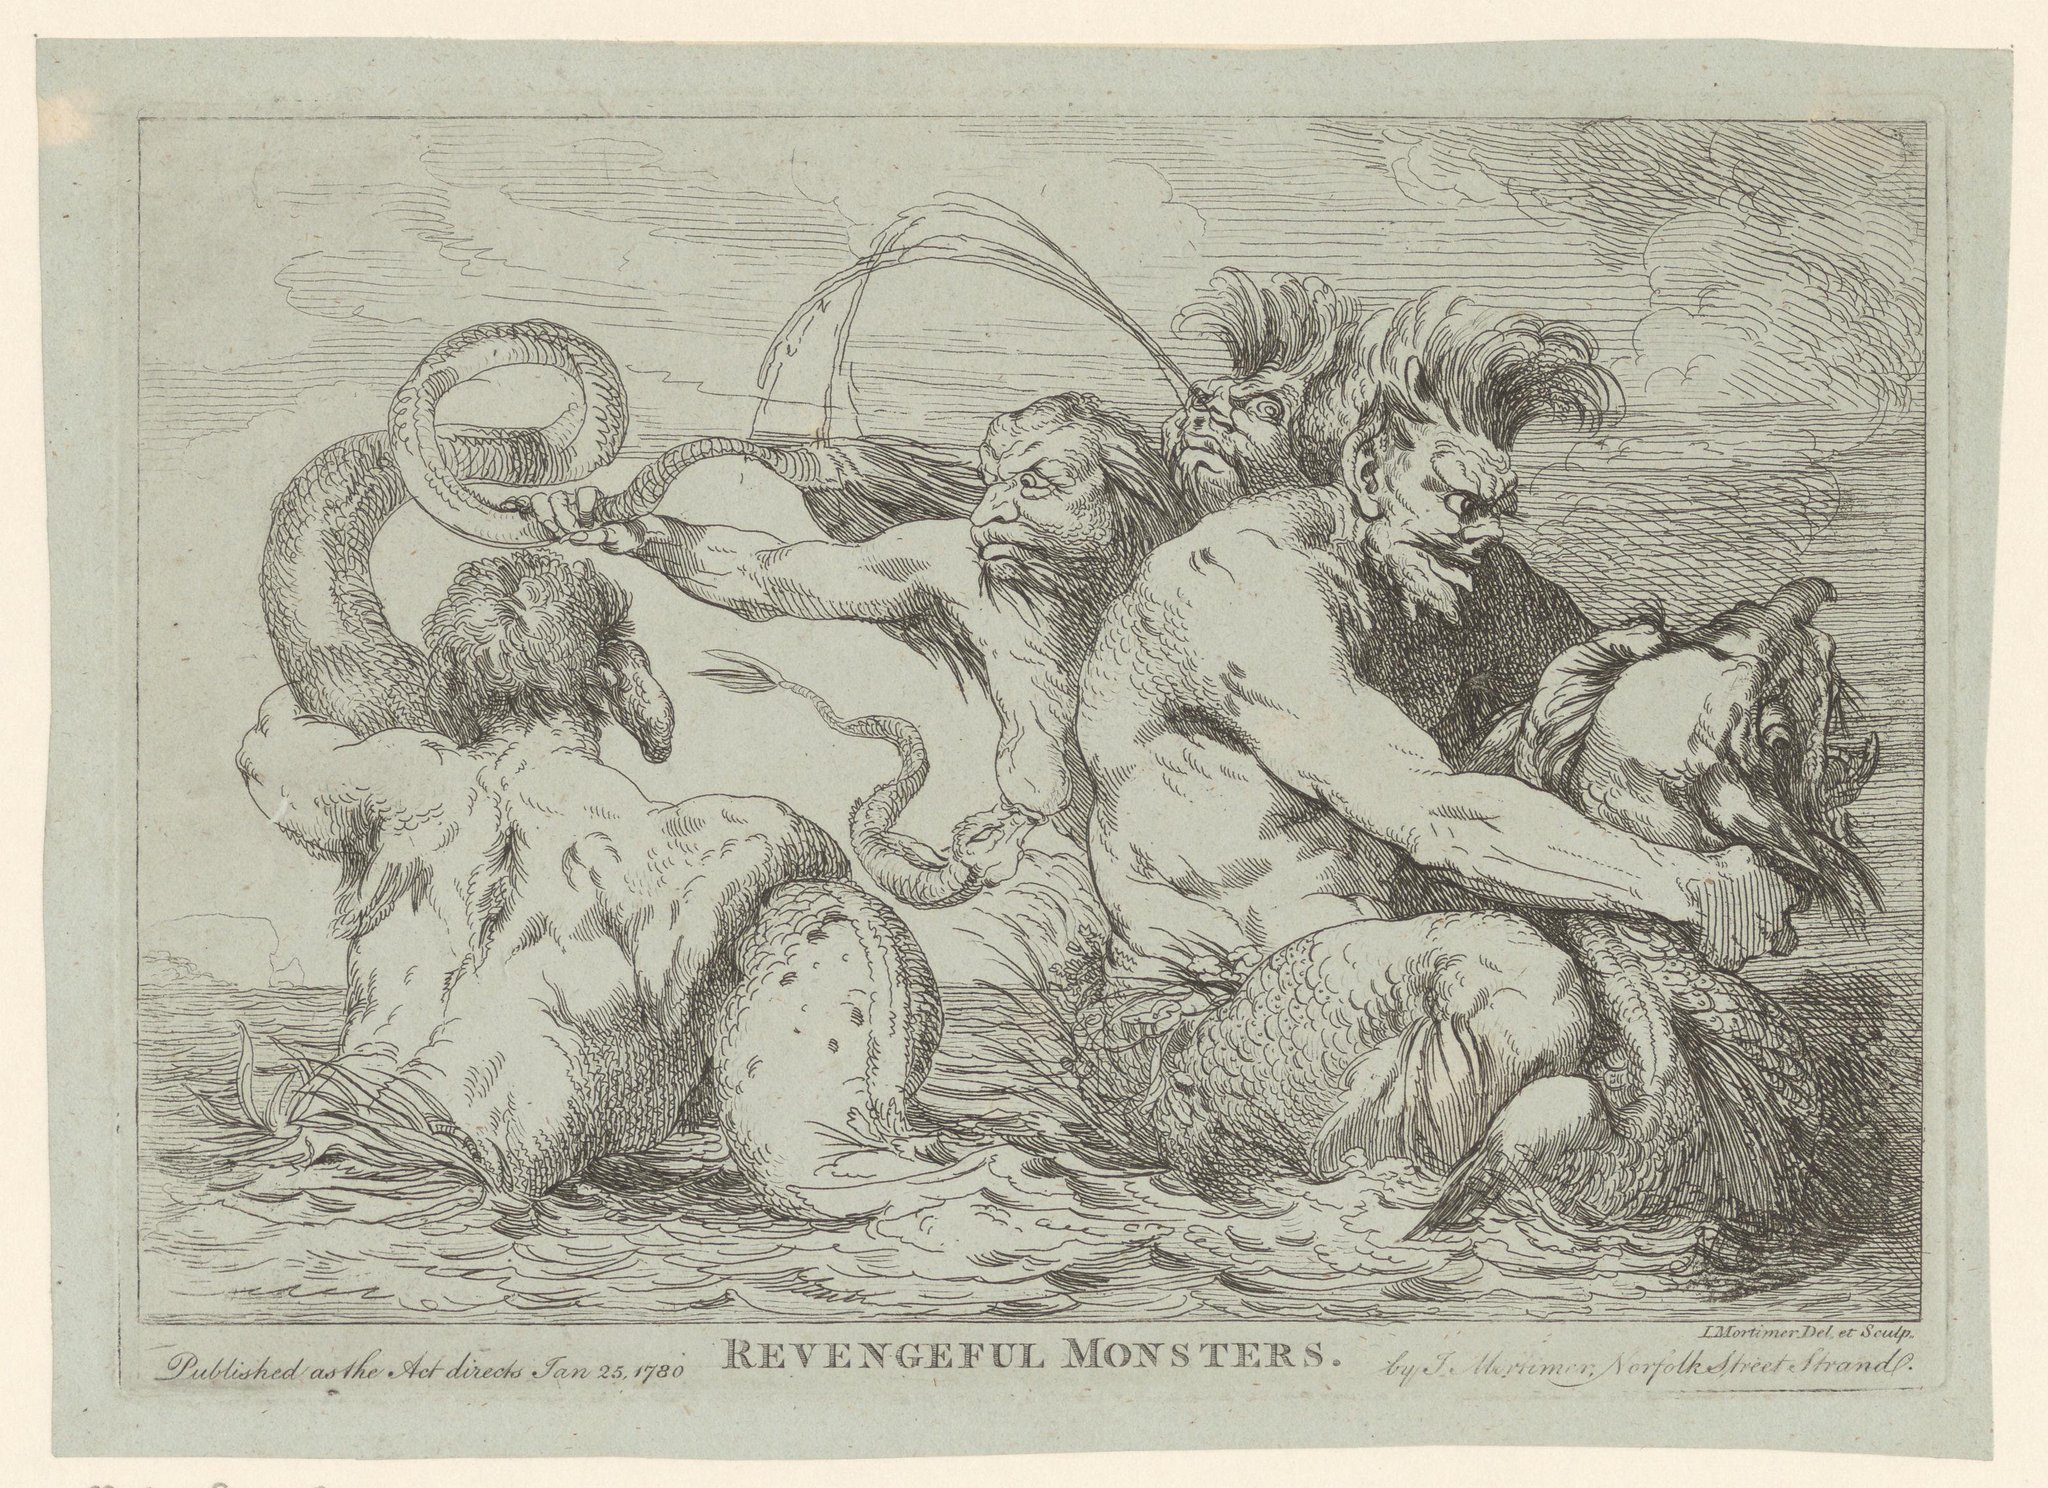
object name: print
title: Revengeful Monsters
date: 1780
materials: paper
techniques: etching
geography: london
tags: merman, monsters ~ fishes, killing ~ aggressive relationships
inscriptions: collector's mark: Lugt 2228, collector's mark: Lugt 2760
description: Onderdeel van een reeks van twaalf prenten die postuum werd gepubliceerd door Mortimers weduwe.